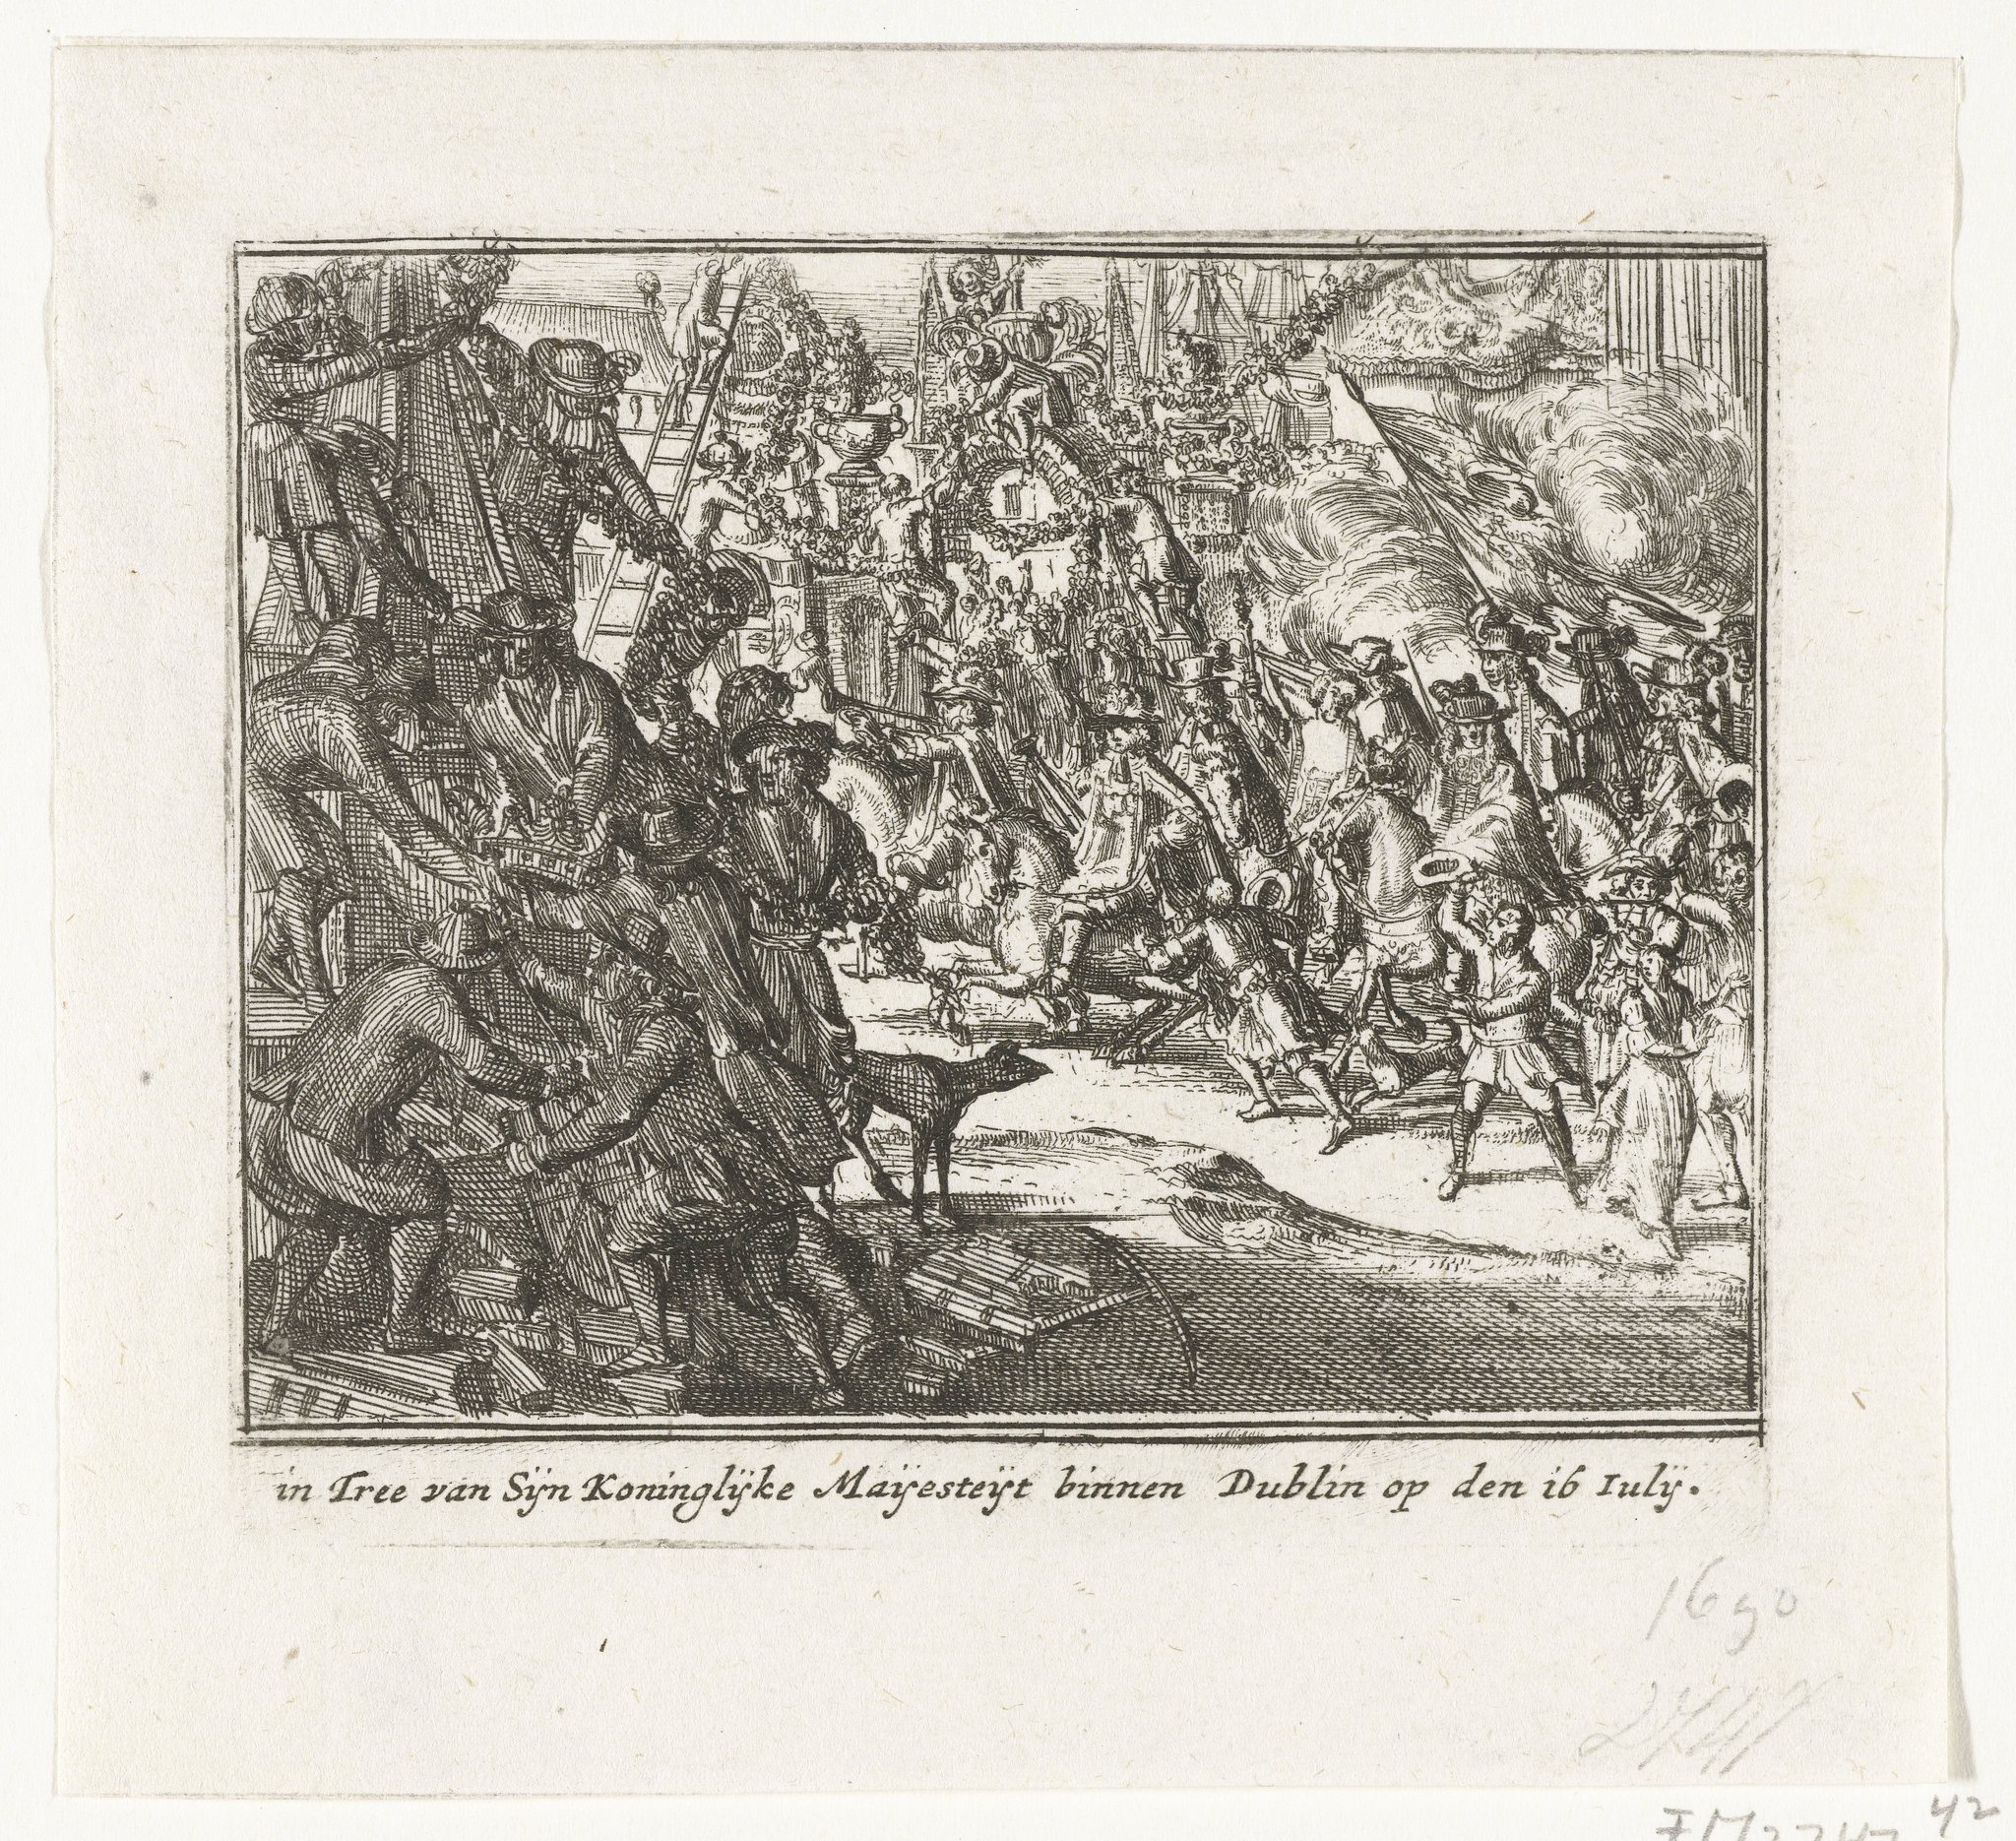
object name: history print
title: in Tree van Syn Koninglyke Mayesteyt binnen Dublin op den 16 July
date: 1711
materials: paper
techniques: etching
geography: amsterdam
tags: william iii (prince of orange and king of england, scotland, and ireland)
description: Koning Willem III trekt met zijn legers Dublin in, 16 juli 1690. Onderdeel van een serie over de lotgevallen van het Engelse koningshuis van Stuart van 1558-1711, waarvan hier zijn opgenomen zestien prenten over de strijd tussen Jacobus II en Willem III in de jaren 1688-1689.